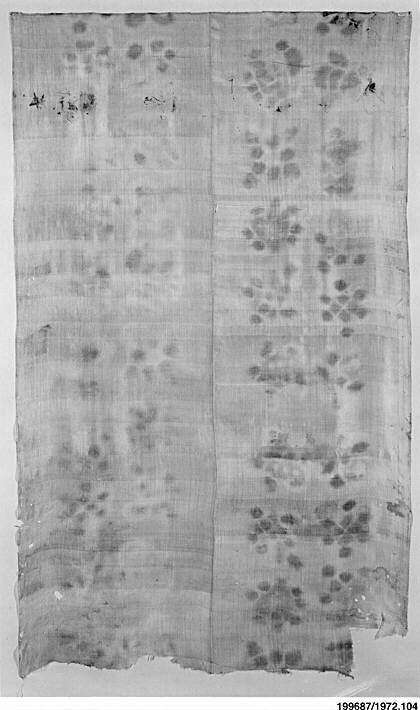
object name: thangka curtain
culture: nepalese or tibetan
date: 1601-1700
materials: silk